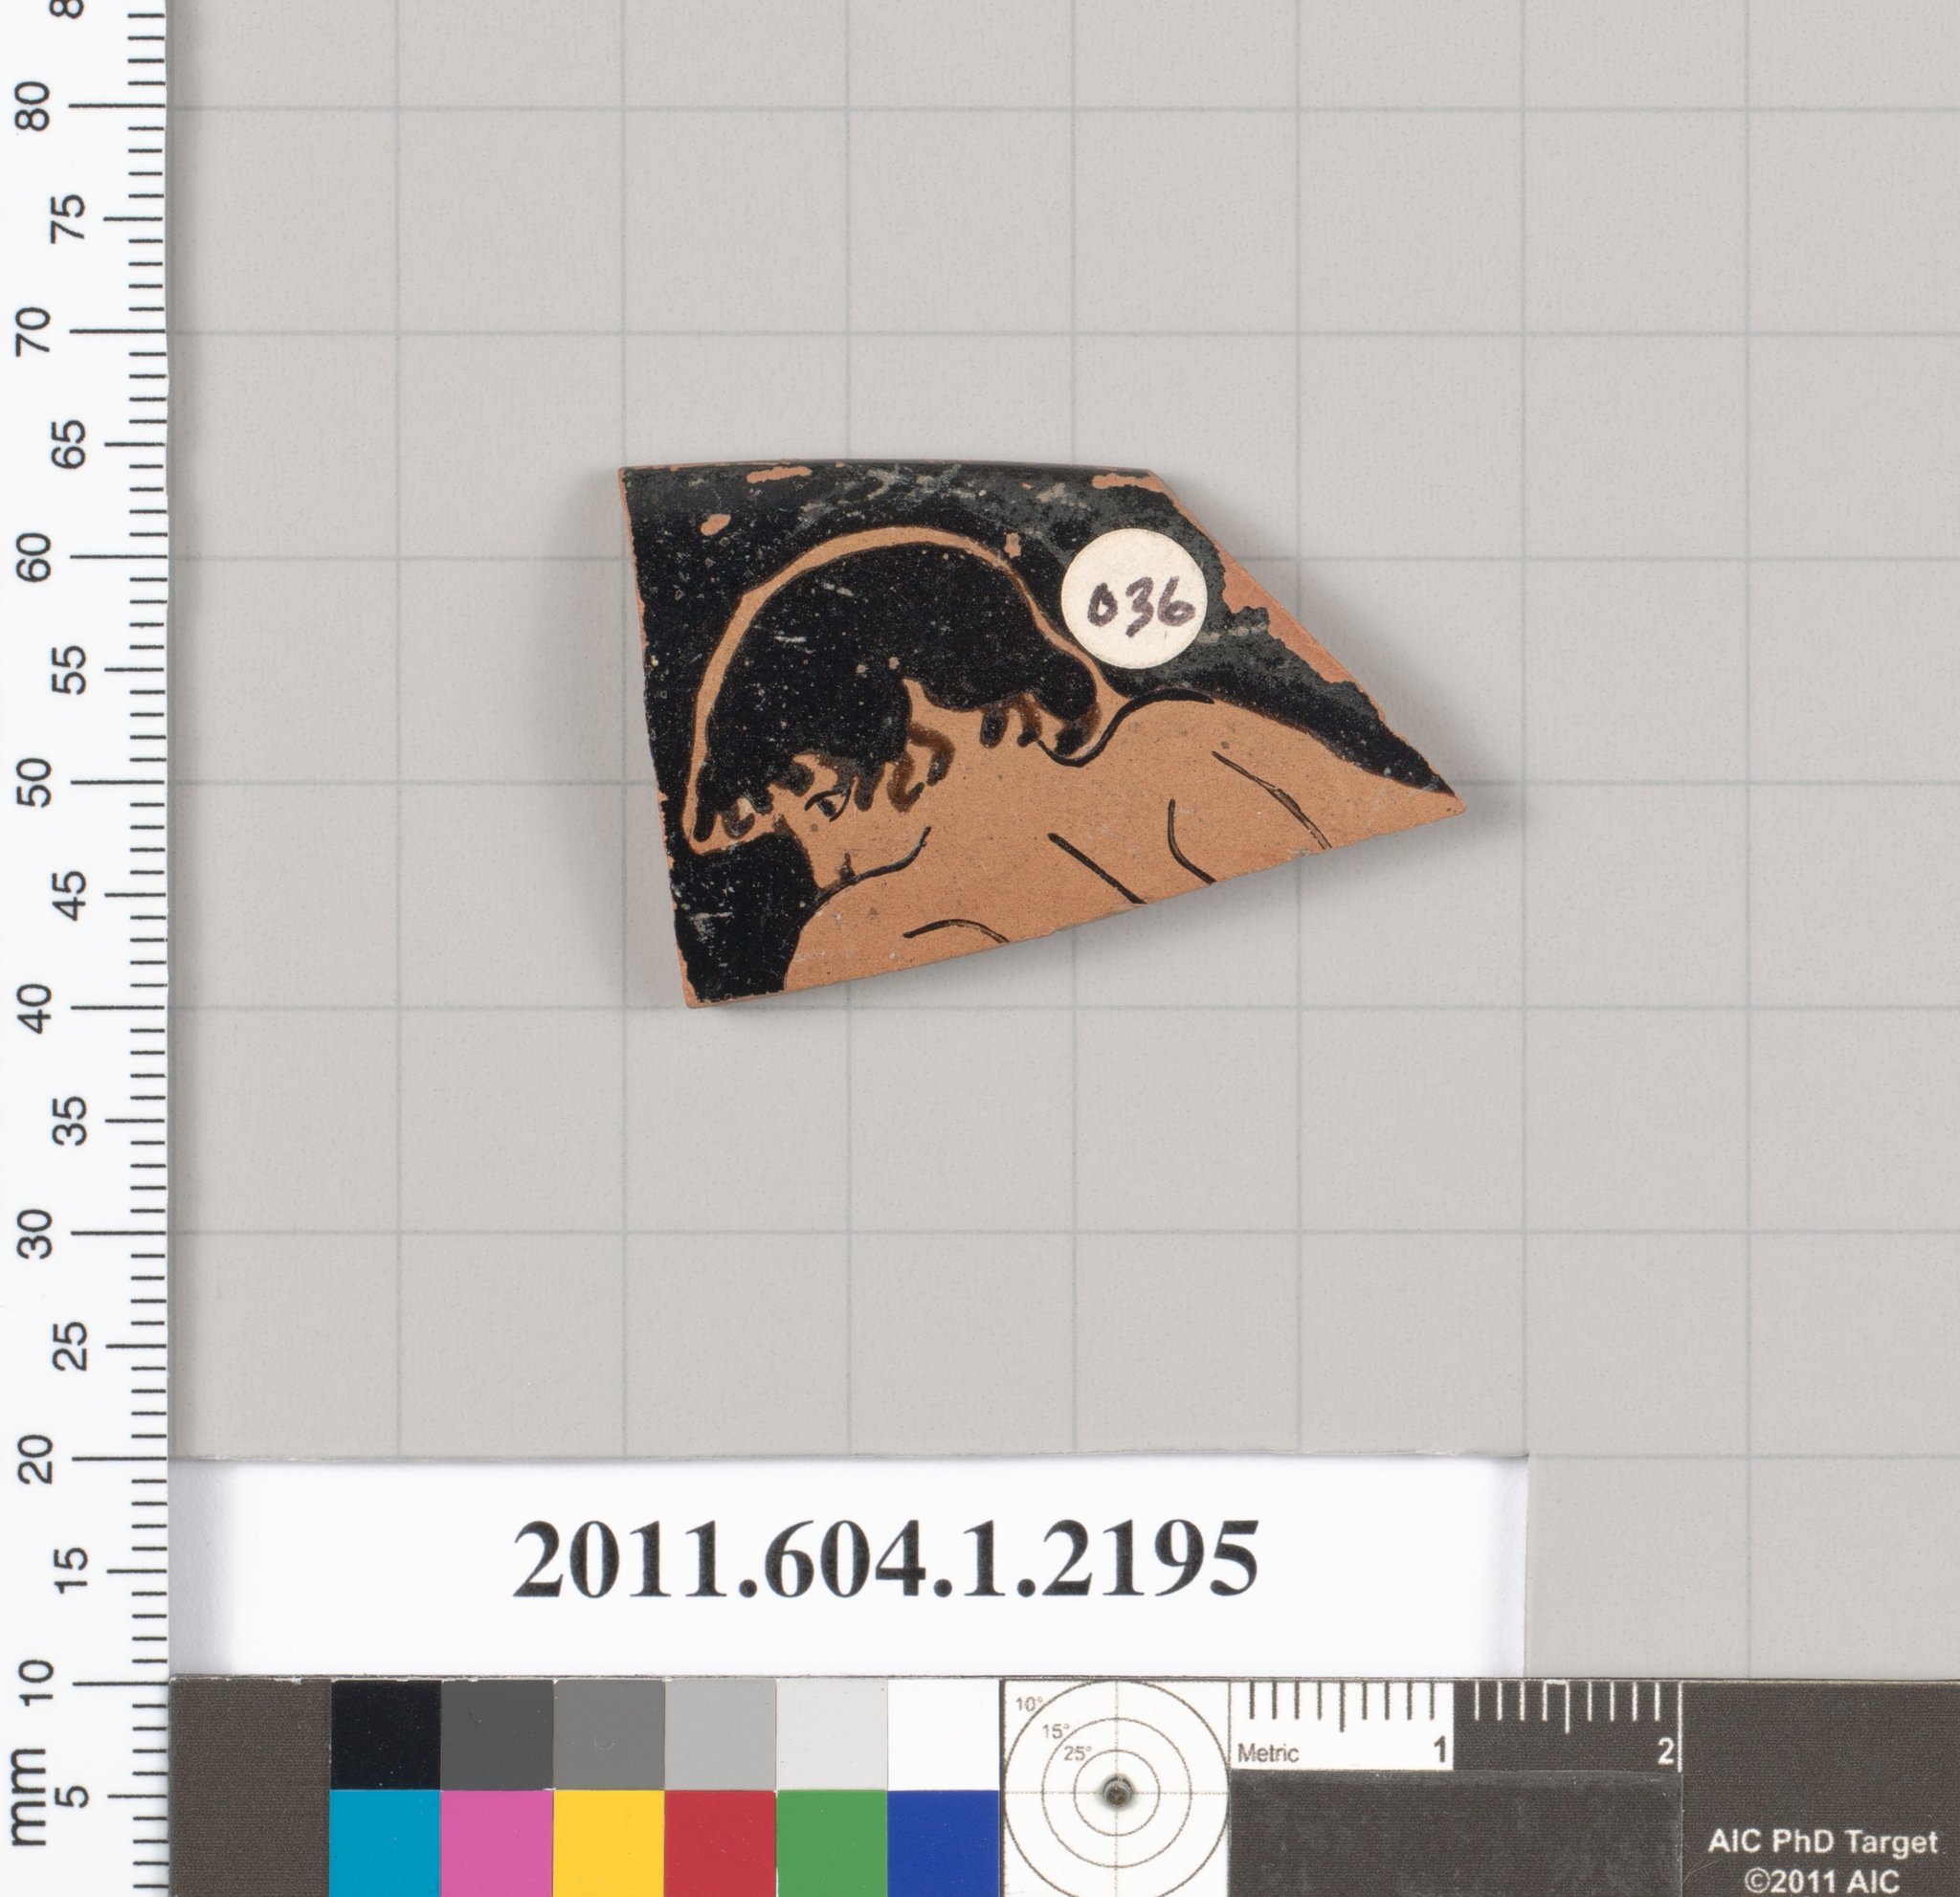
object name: kylix fragment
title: Terracotta rim fragment of a kylix (drinking cup)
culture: greek, attic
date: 460-450 BCE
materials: terracotta